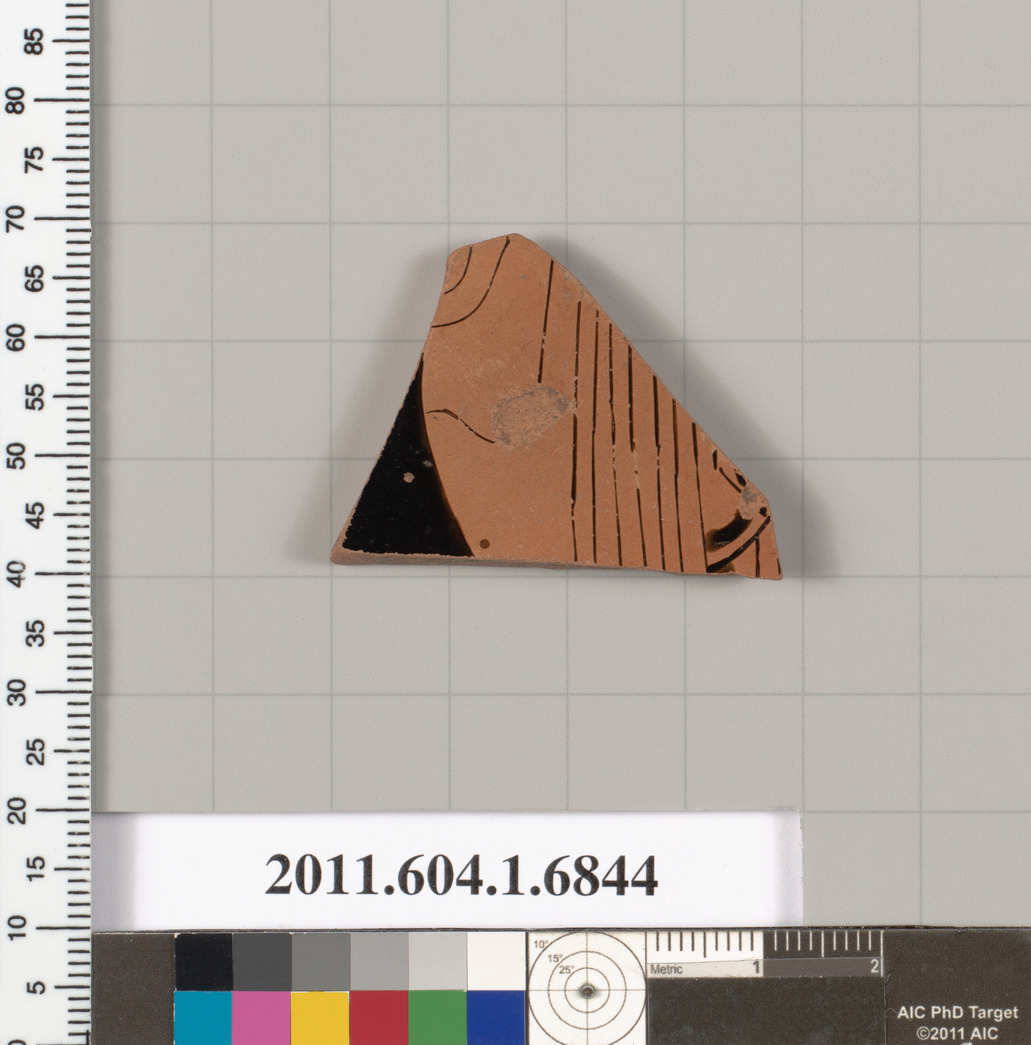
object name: kylix fragment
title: Terracotta fragment of a kylix (drinking cup)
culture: greek, attic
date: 490-470 BCE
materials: terracotta